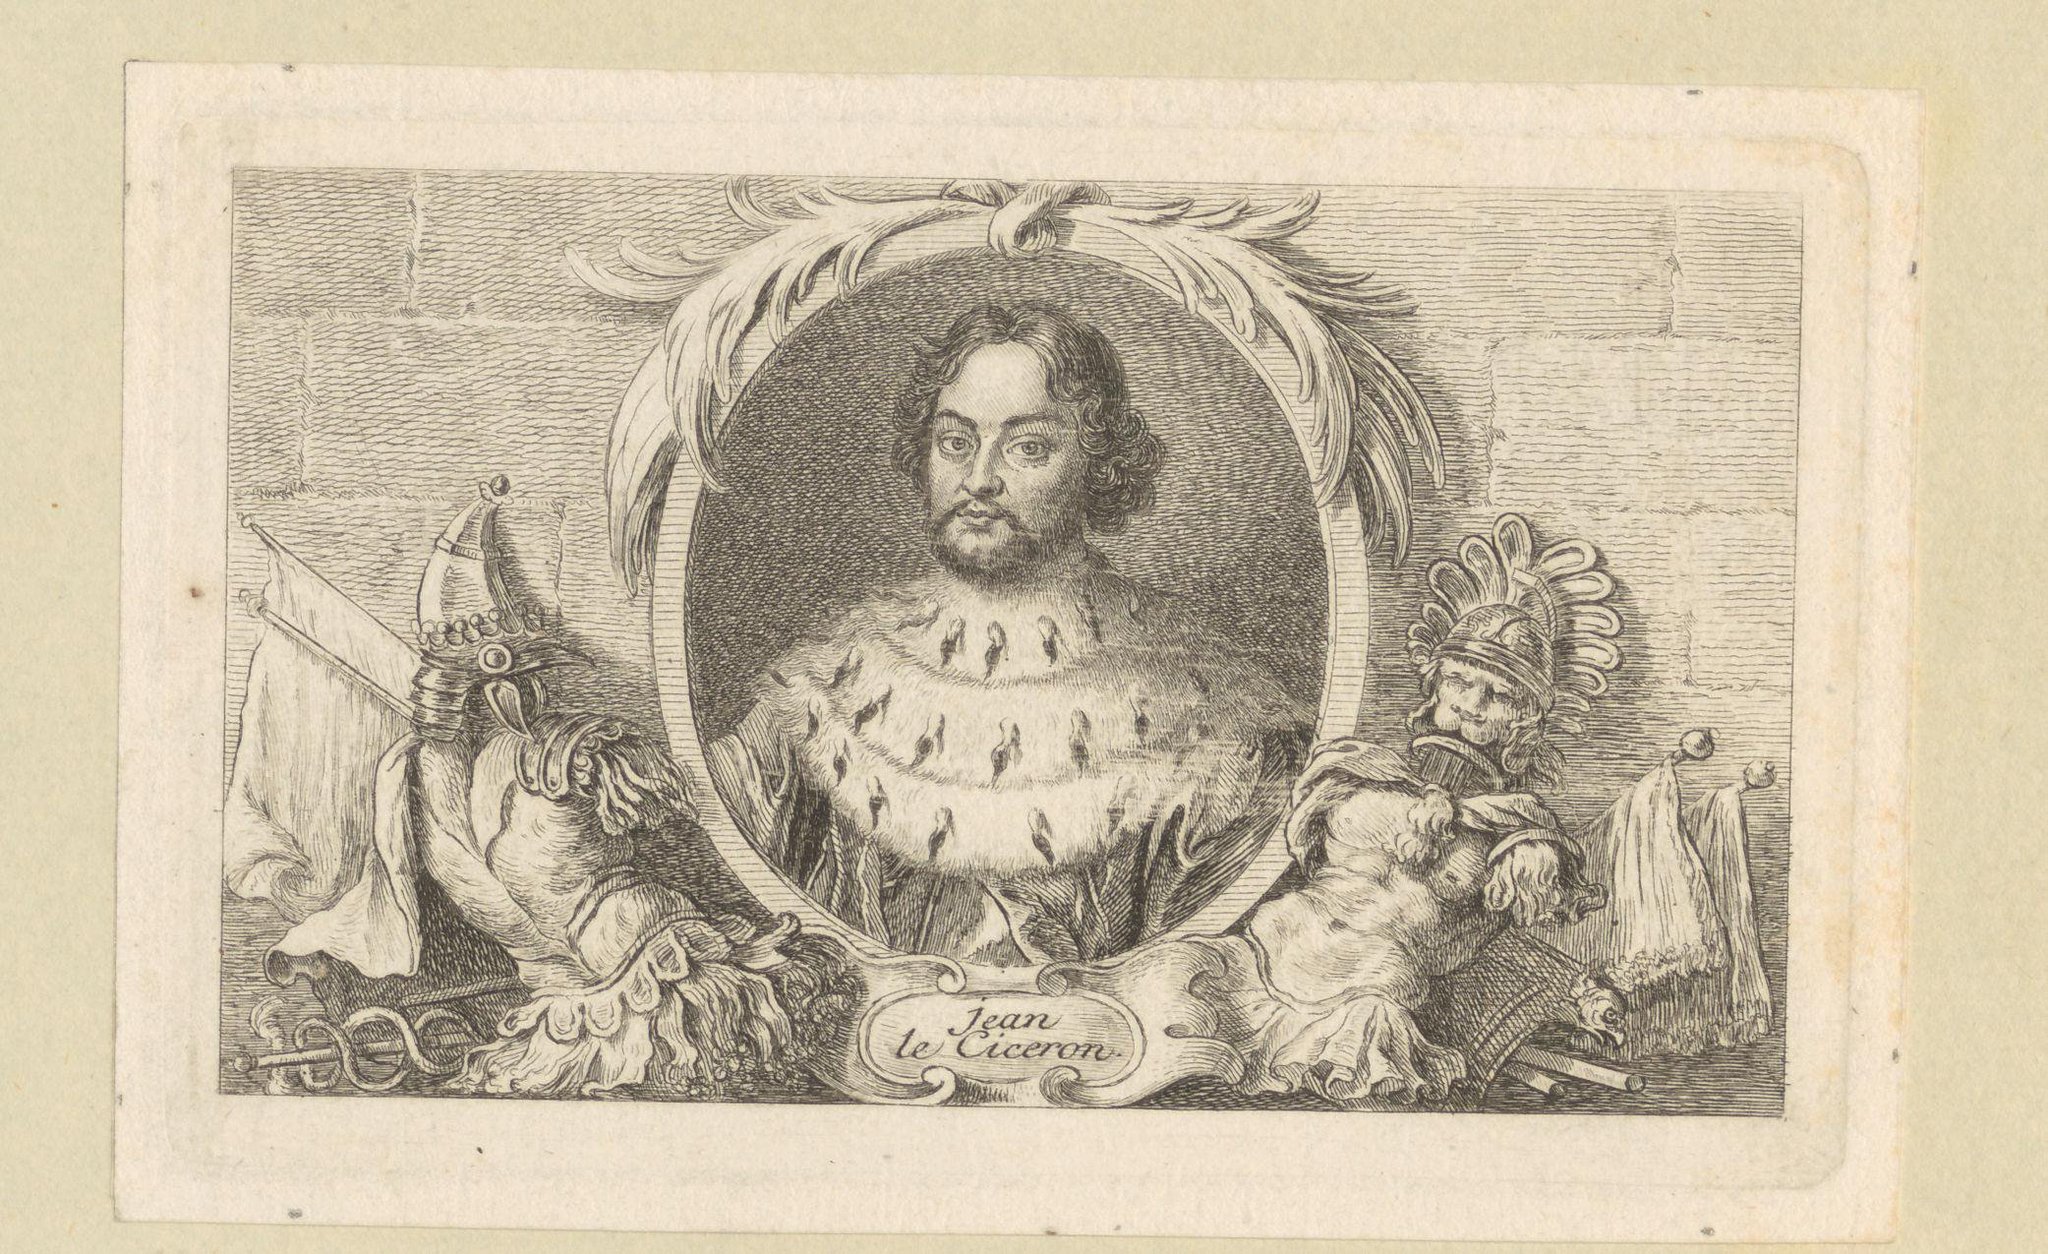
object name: book illustration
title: Portret van Johann Cicero van Brandenburg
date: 1751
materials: paper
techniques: etching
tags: historical persons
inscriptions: collector's mark: Lugt 240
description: Prent ook gebruikt in: Frederik de Grote. Mémoires pour servir a l'histoire de la maison de Brandebourg. Sanssouci, Frederik de Grote, 1751.